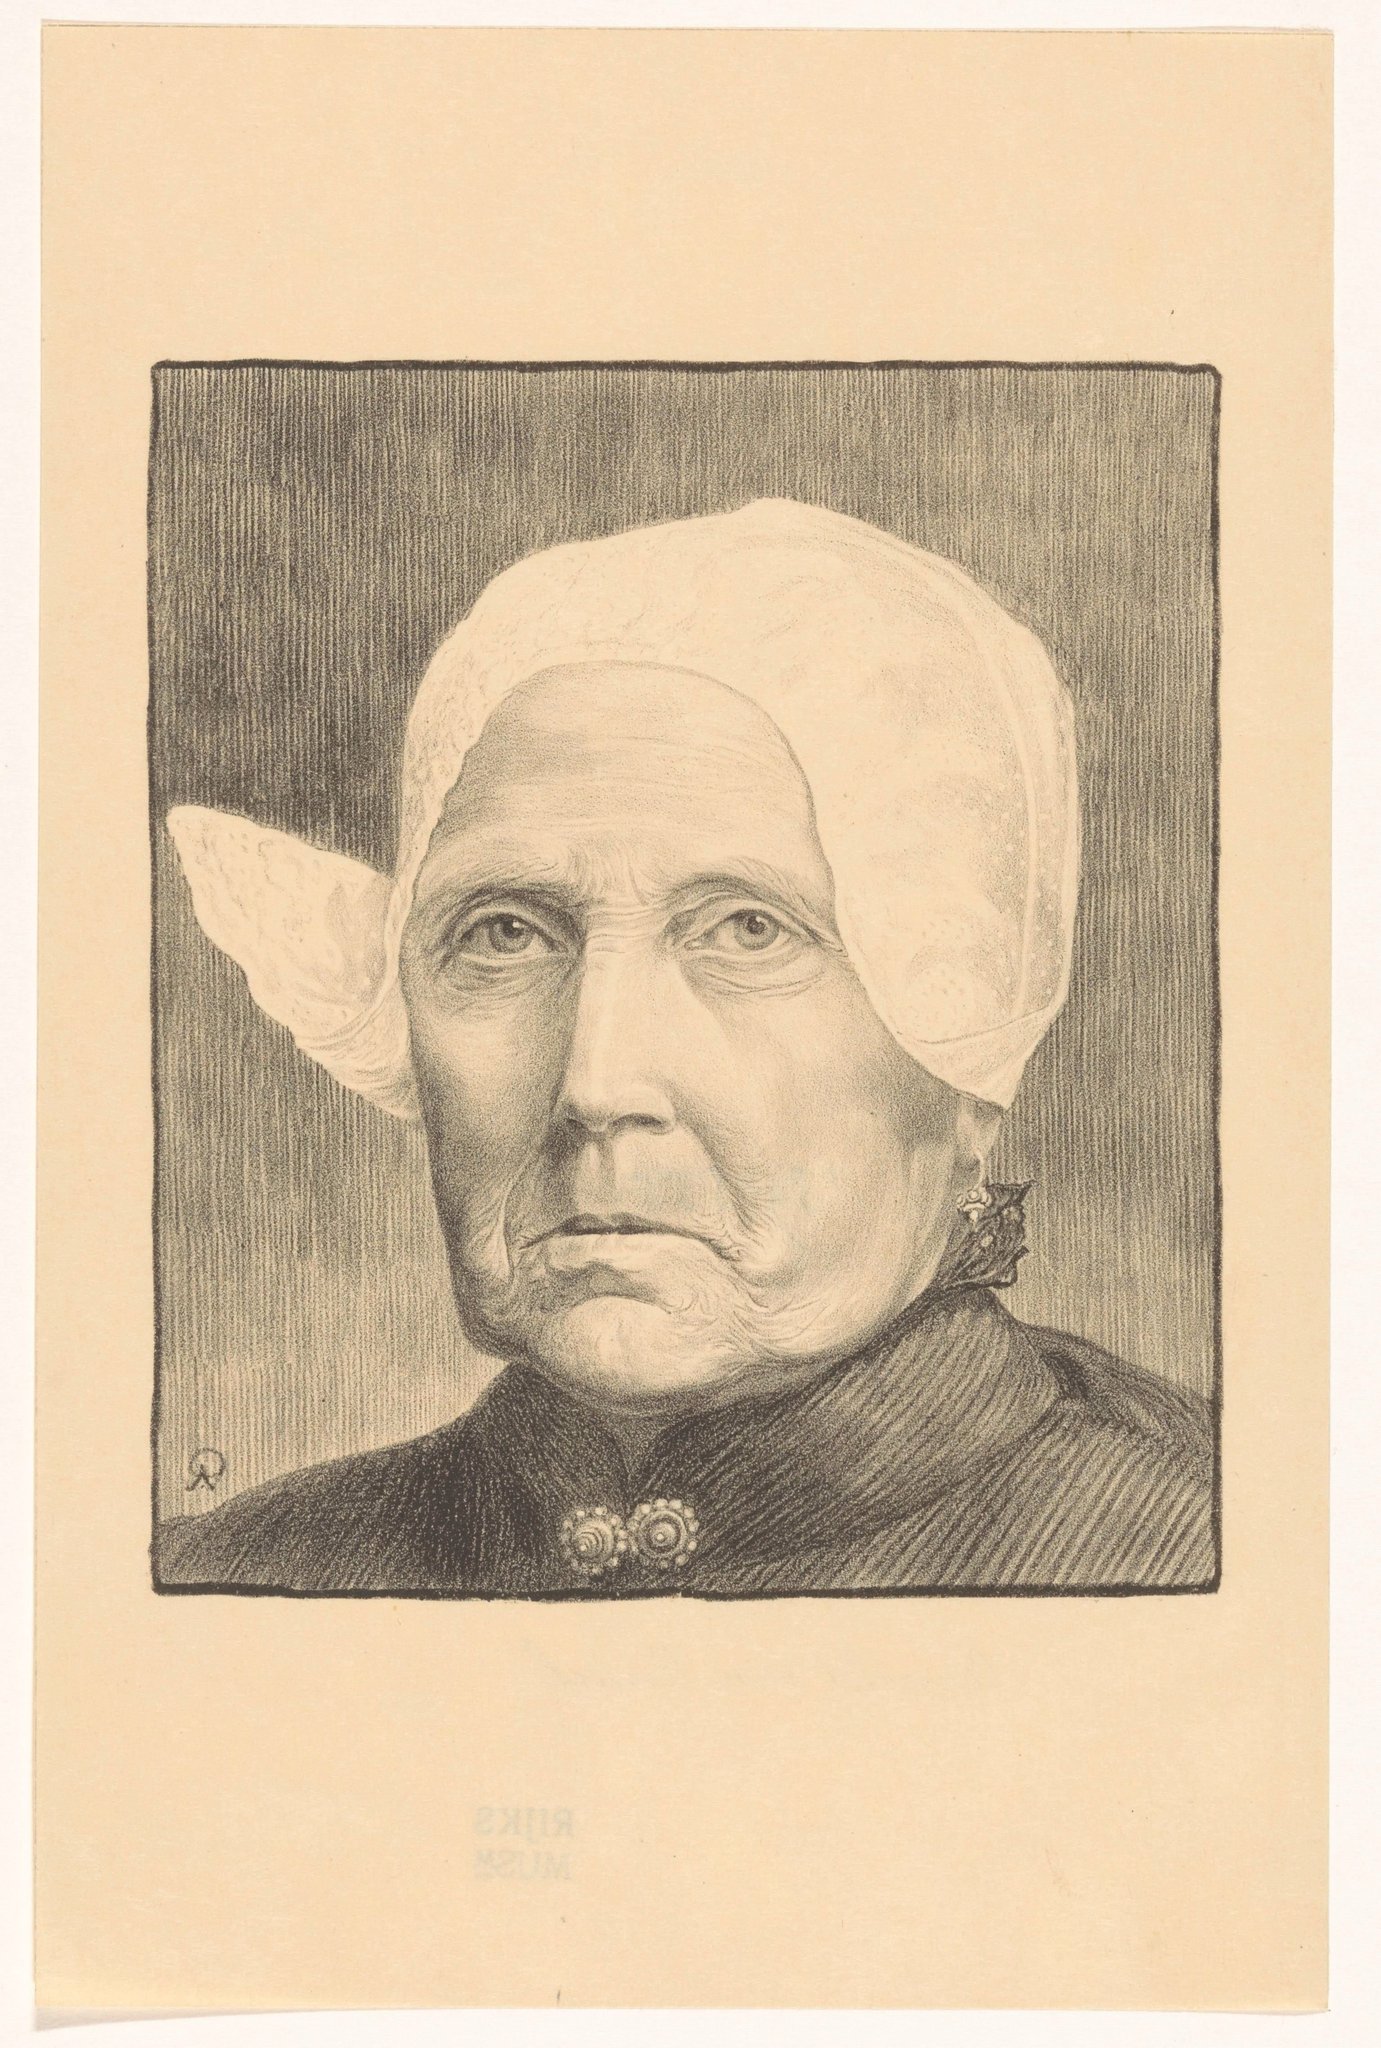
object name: print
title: Portret van een onbekende vrouw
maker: arnold van roessel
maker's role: print maker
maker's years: 1883-1947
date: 1893-1939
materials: paper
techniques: lithograph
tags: folk costume, regional costume, anonymous historical person portrayed - bb - woman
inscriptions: collector's mark: Lugt 2760, collector's mark: Lugt 2166